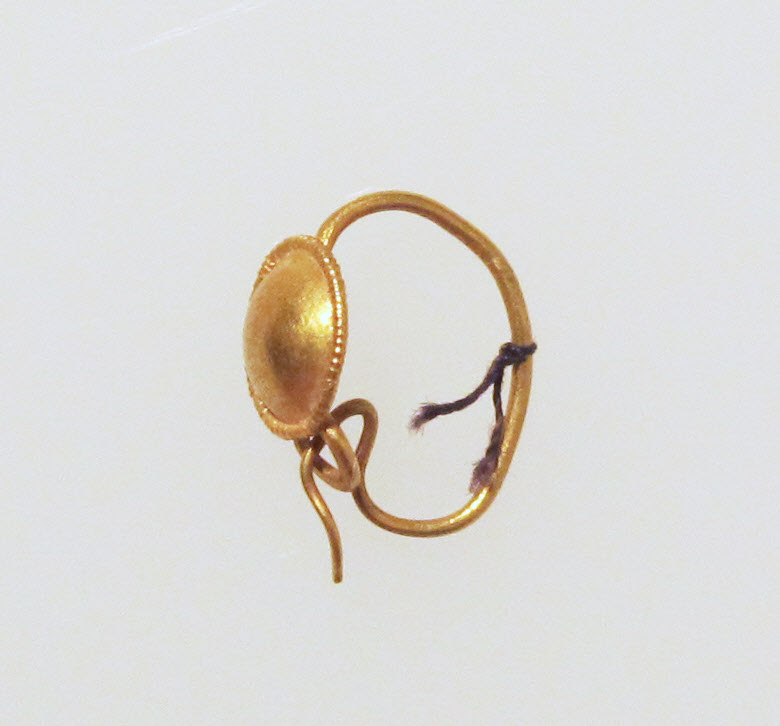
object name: earring with plain loop and disc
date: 7000 BCE-330 CE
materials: gold